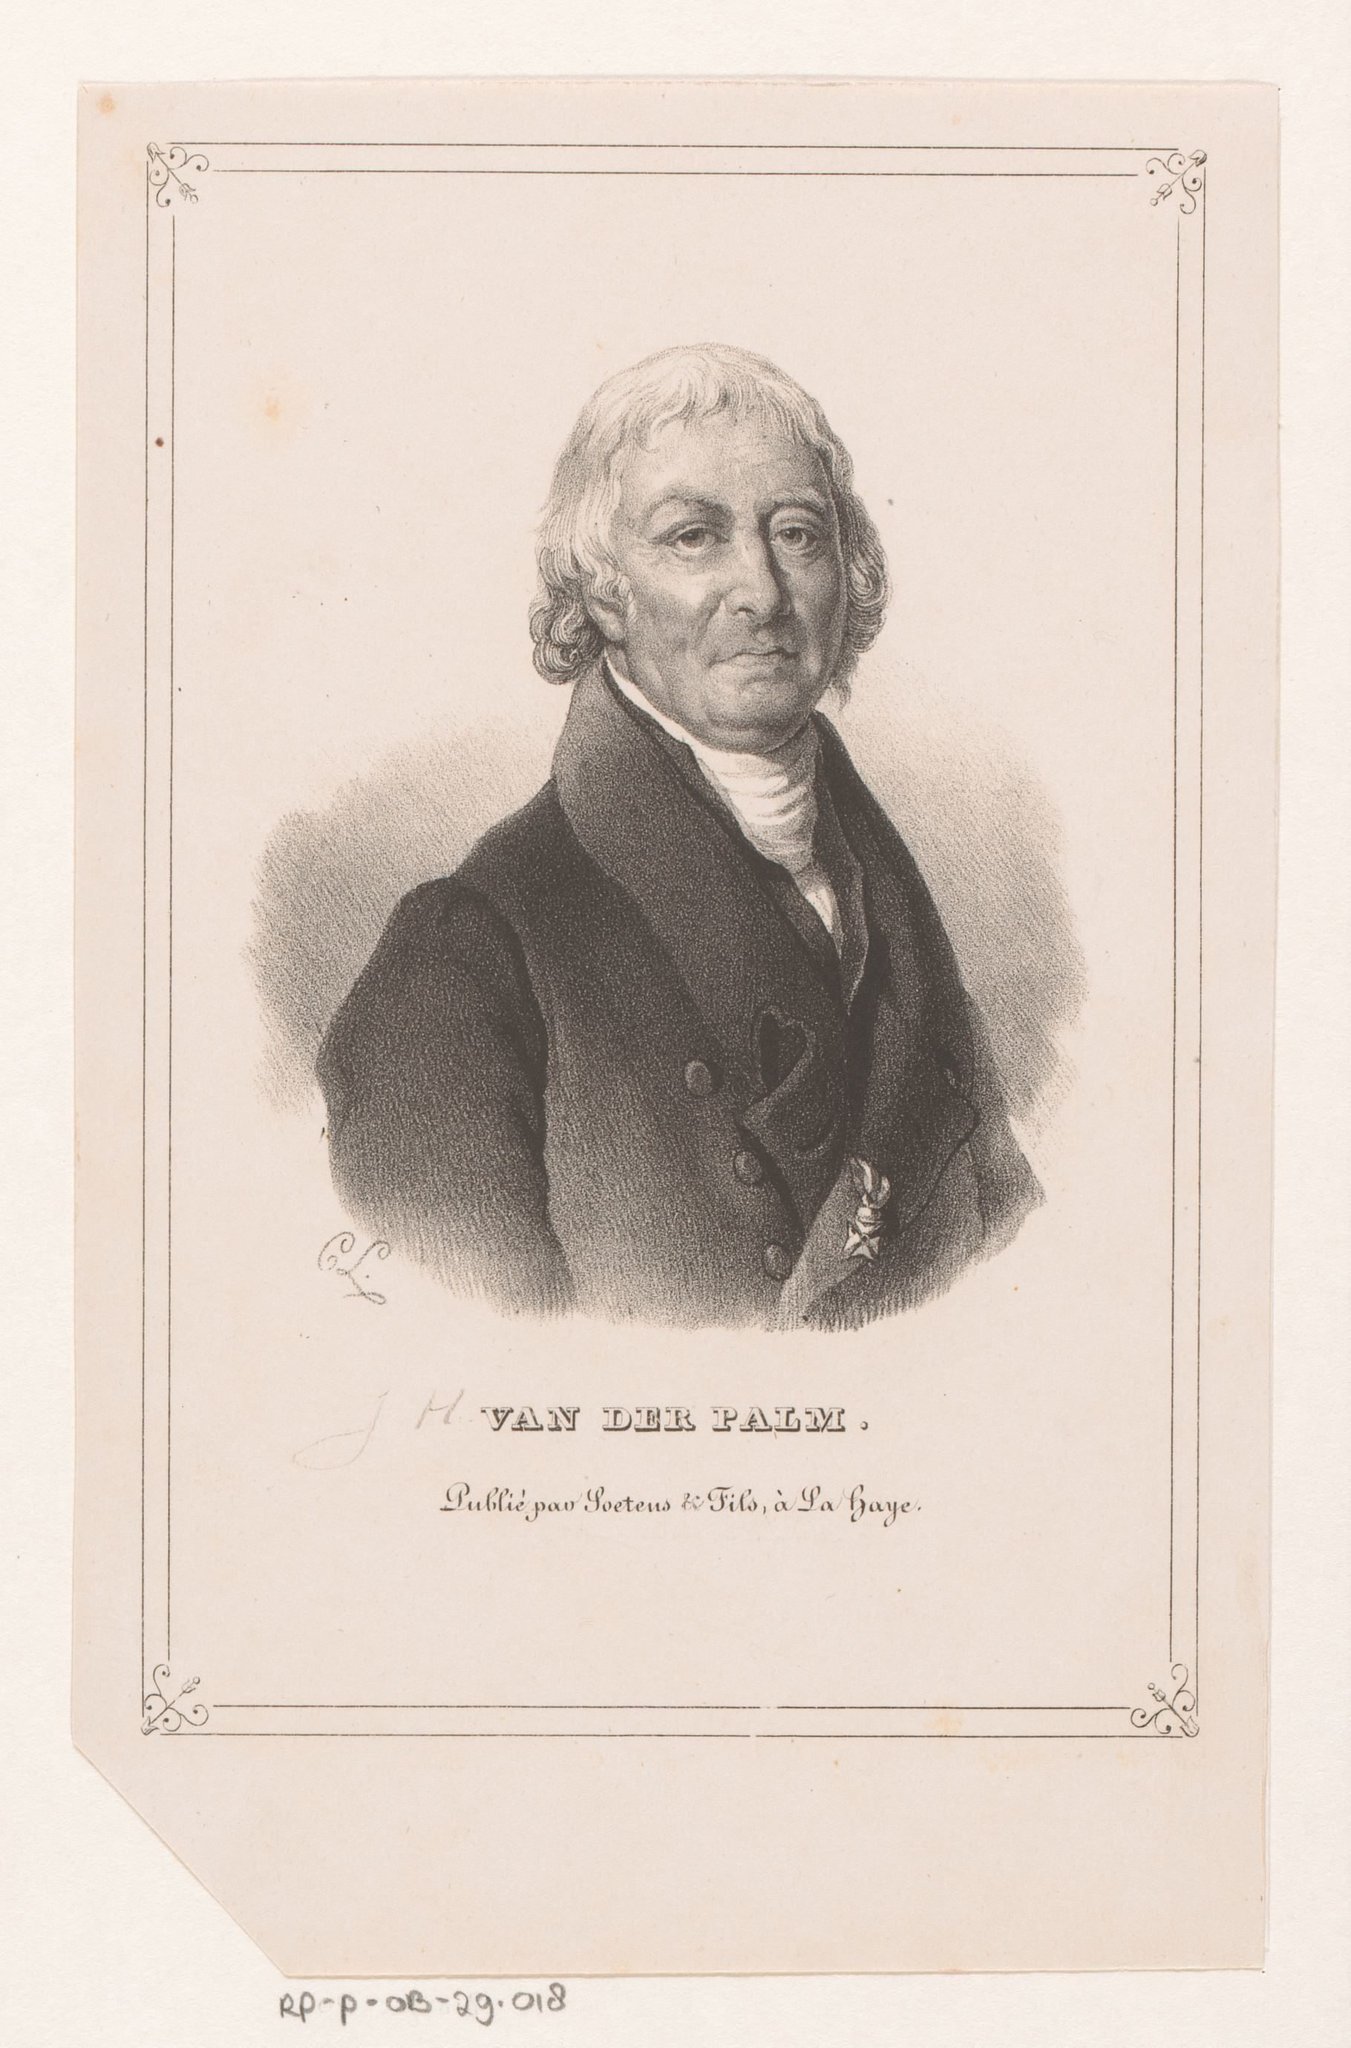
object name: print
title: Portret Johannes Henricus van der Palm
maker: carel christiaan antony last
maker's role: print maker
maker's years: 1808-1876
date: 1837-1840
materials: paper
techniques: lithograph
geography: the hague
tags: historical persons (+ (full) bust portrait)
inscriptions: collector's mark: Lugt 2228